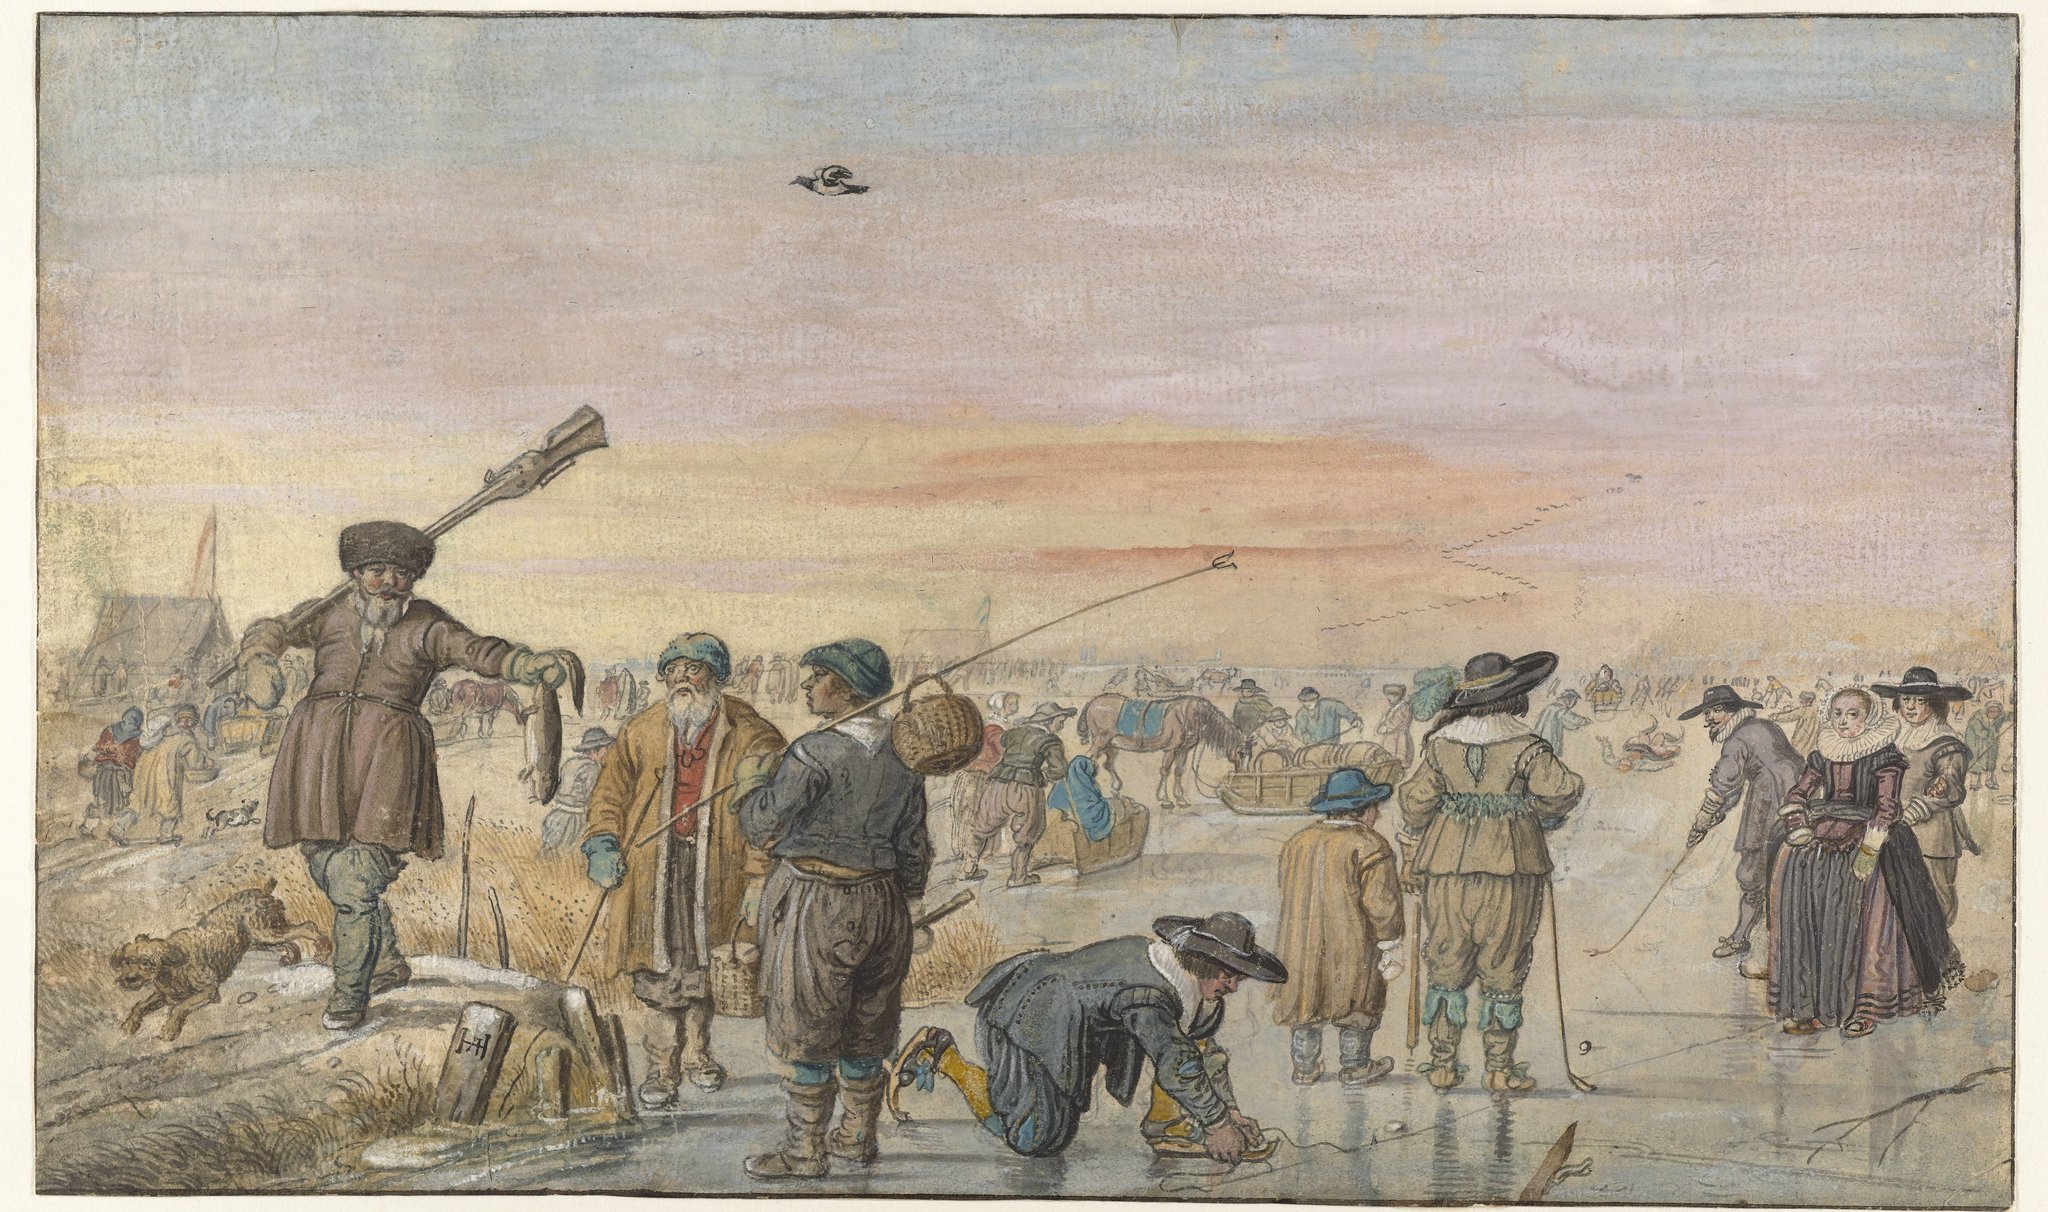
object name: drawing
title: Winter Scene on the Ice, with a Hunter Showing an Otter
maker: hendrick avercamp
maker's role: draughtsman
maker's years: 1585-1634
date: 1625-1630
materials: chalk, paint, graphite, ink, paper, watercolor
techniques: brush, pen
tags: hunter displaying or presenting the spoils of the hunt, beasts of prey, predatory animals: otter, skates (winter sports), 'kolf' on the ice, small sleigh (winter sports)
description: Talrijke figuren op het ijs; links op de oever staat een jager, die twee vissers een gevangen otter toont.